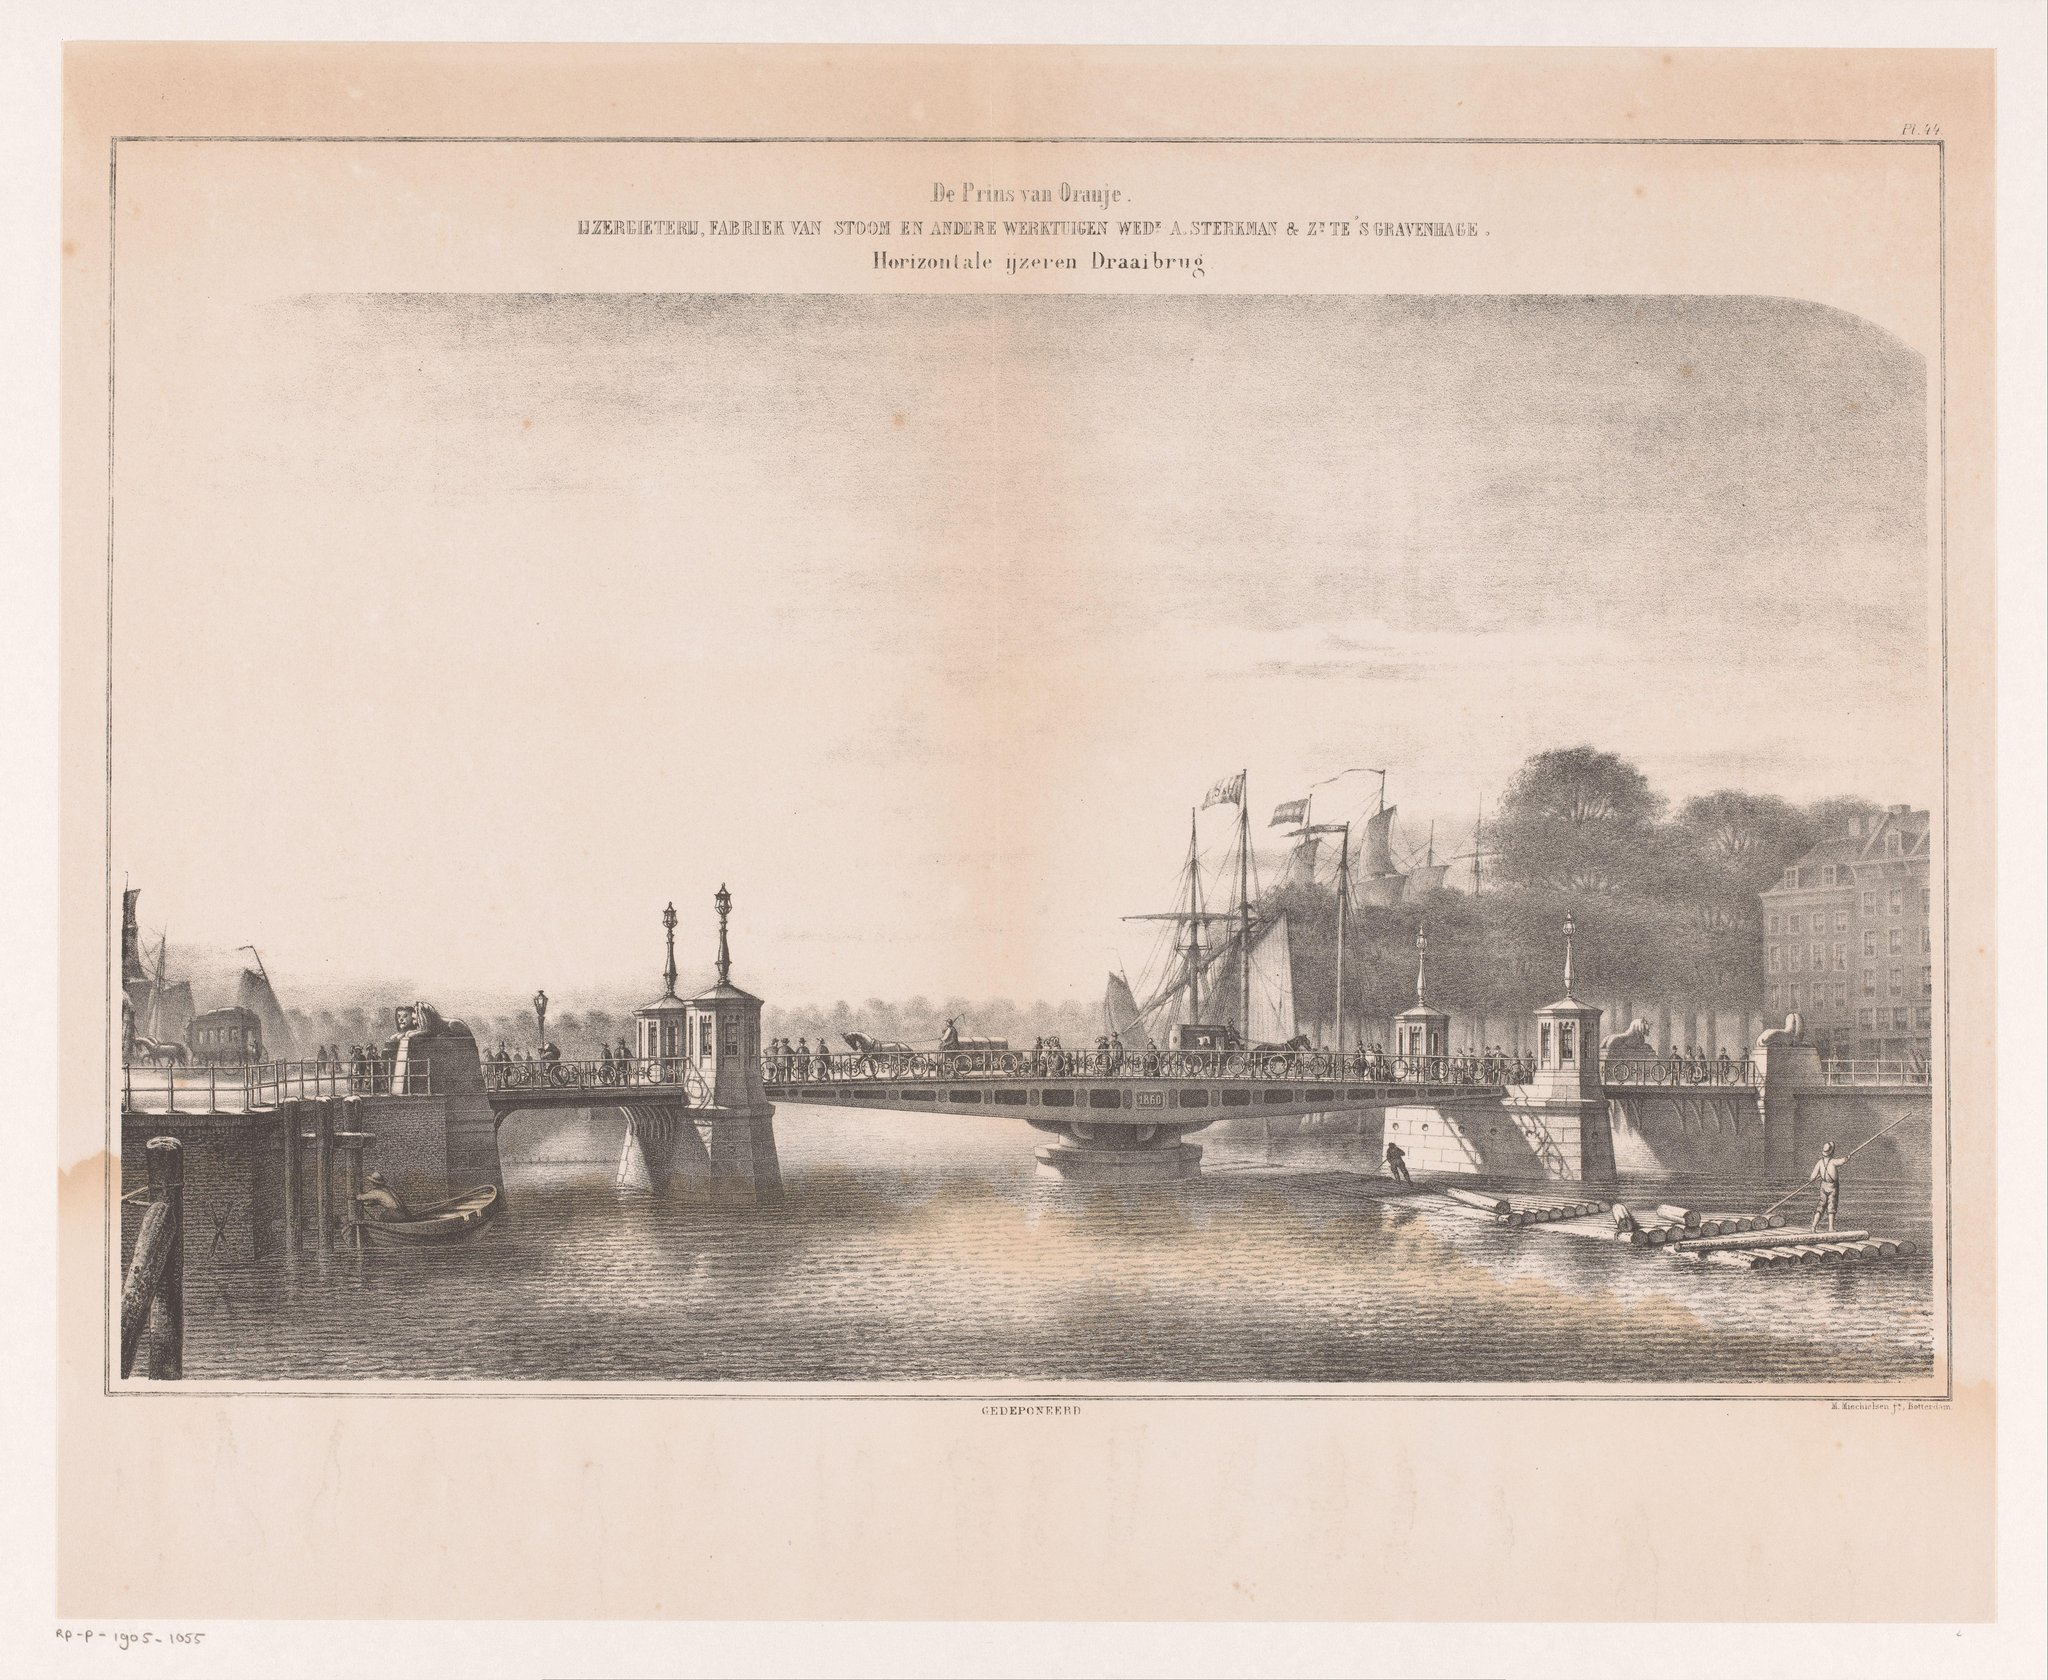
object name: print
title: Koningsbrug in Rotterdam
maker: matthijs willem gerardus michielsen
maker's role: print maker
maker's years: 1824-1876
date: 1861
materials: paper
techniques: lithograph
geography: rotterdam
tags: sailing-ship, sailing-boat, bridge in city across river, canal, etc., beam, log of wood, rotterdam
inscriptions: collector's mark: Lugt 2228, : ‘Gedeponeerd.’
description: Over de ijzeren draaibrug lopen en rijden mensen en rijtuigen. Rechts varen twee figuren op boomstammen onder de brug door. Links en rechts steken de masten van zeilschepen boven de boomtoppen uit. Genummerd rechtsboven: Pl. 44.